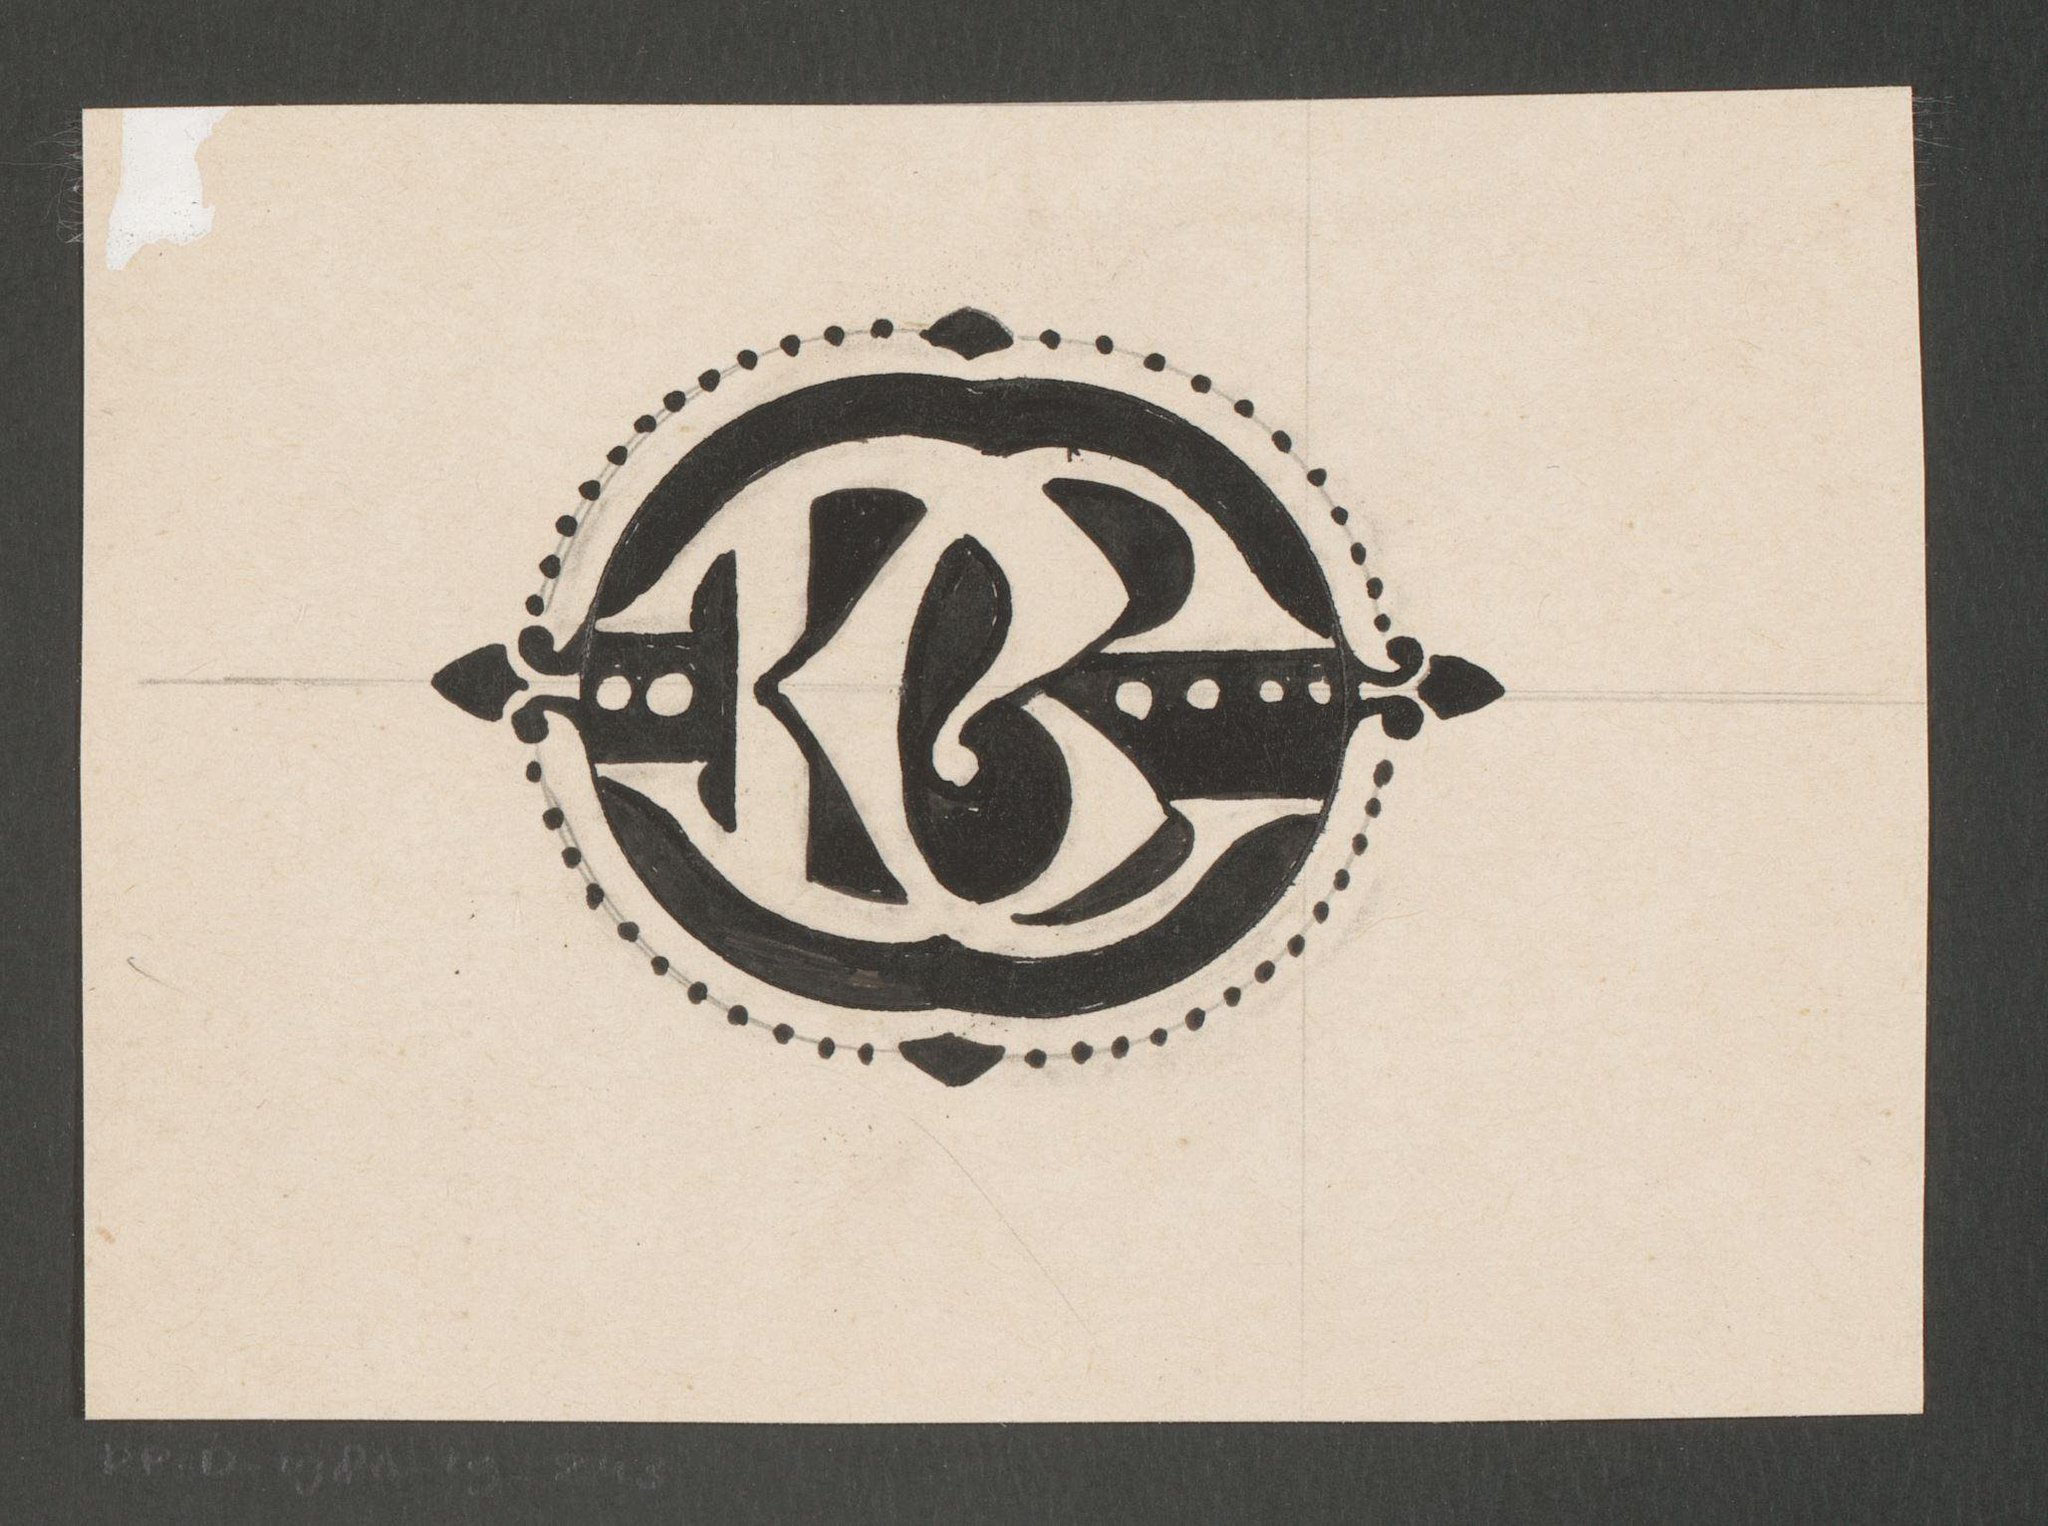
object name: drawing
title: Monogram BC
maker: reinier willem petrus de vries (1874-1953)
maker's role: draughtsman, print maker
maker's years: 1874-1953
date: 1884-1952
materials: ink, paper, pencil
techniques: brush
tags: magic mathematical figures; magic numbers, words, monograms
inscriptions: collector's mark: ‘R:MVS.’